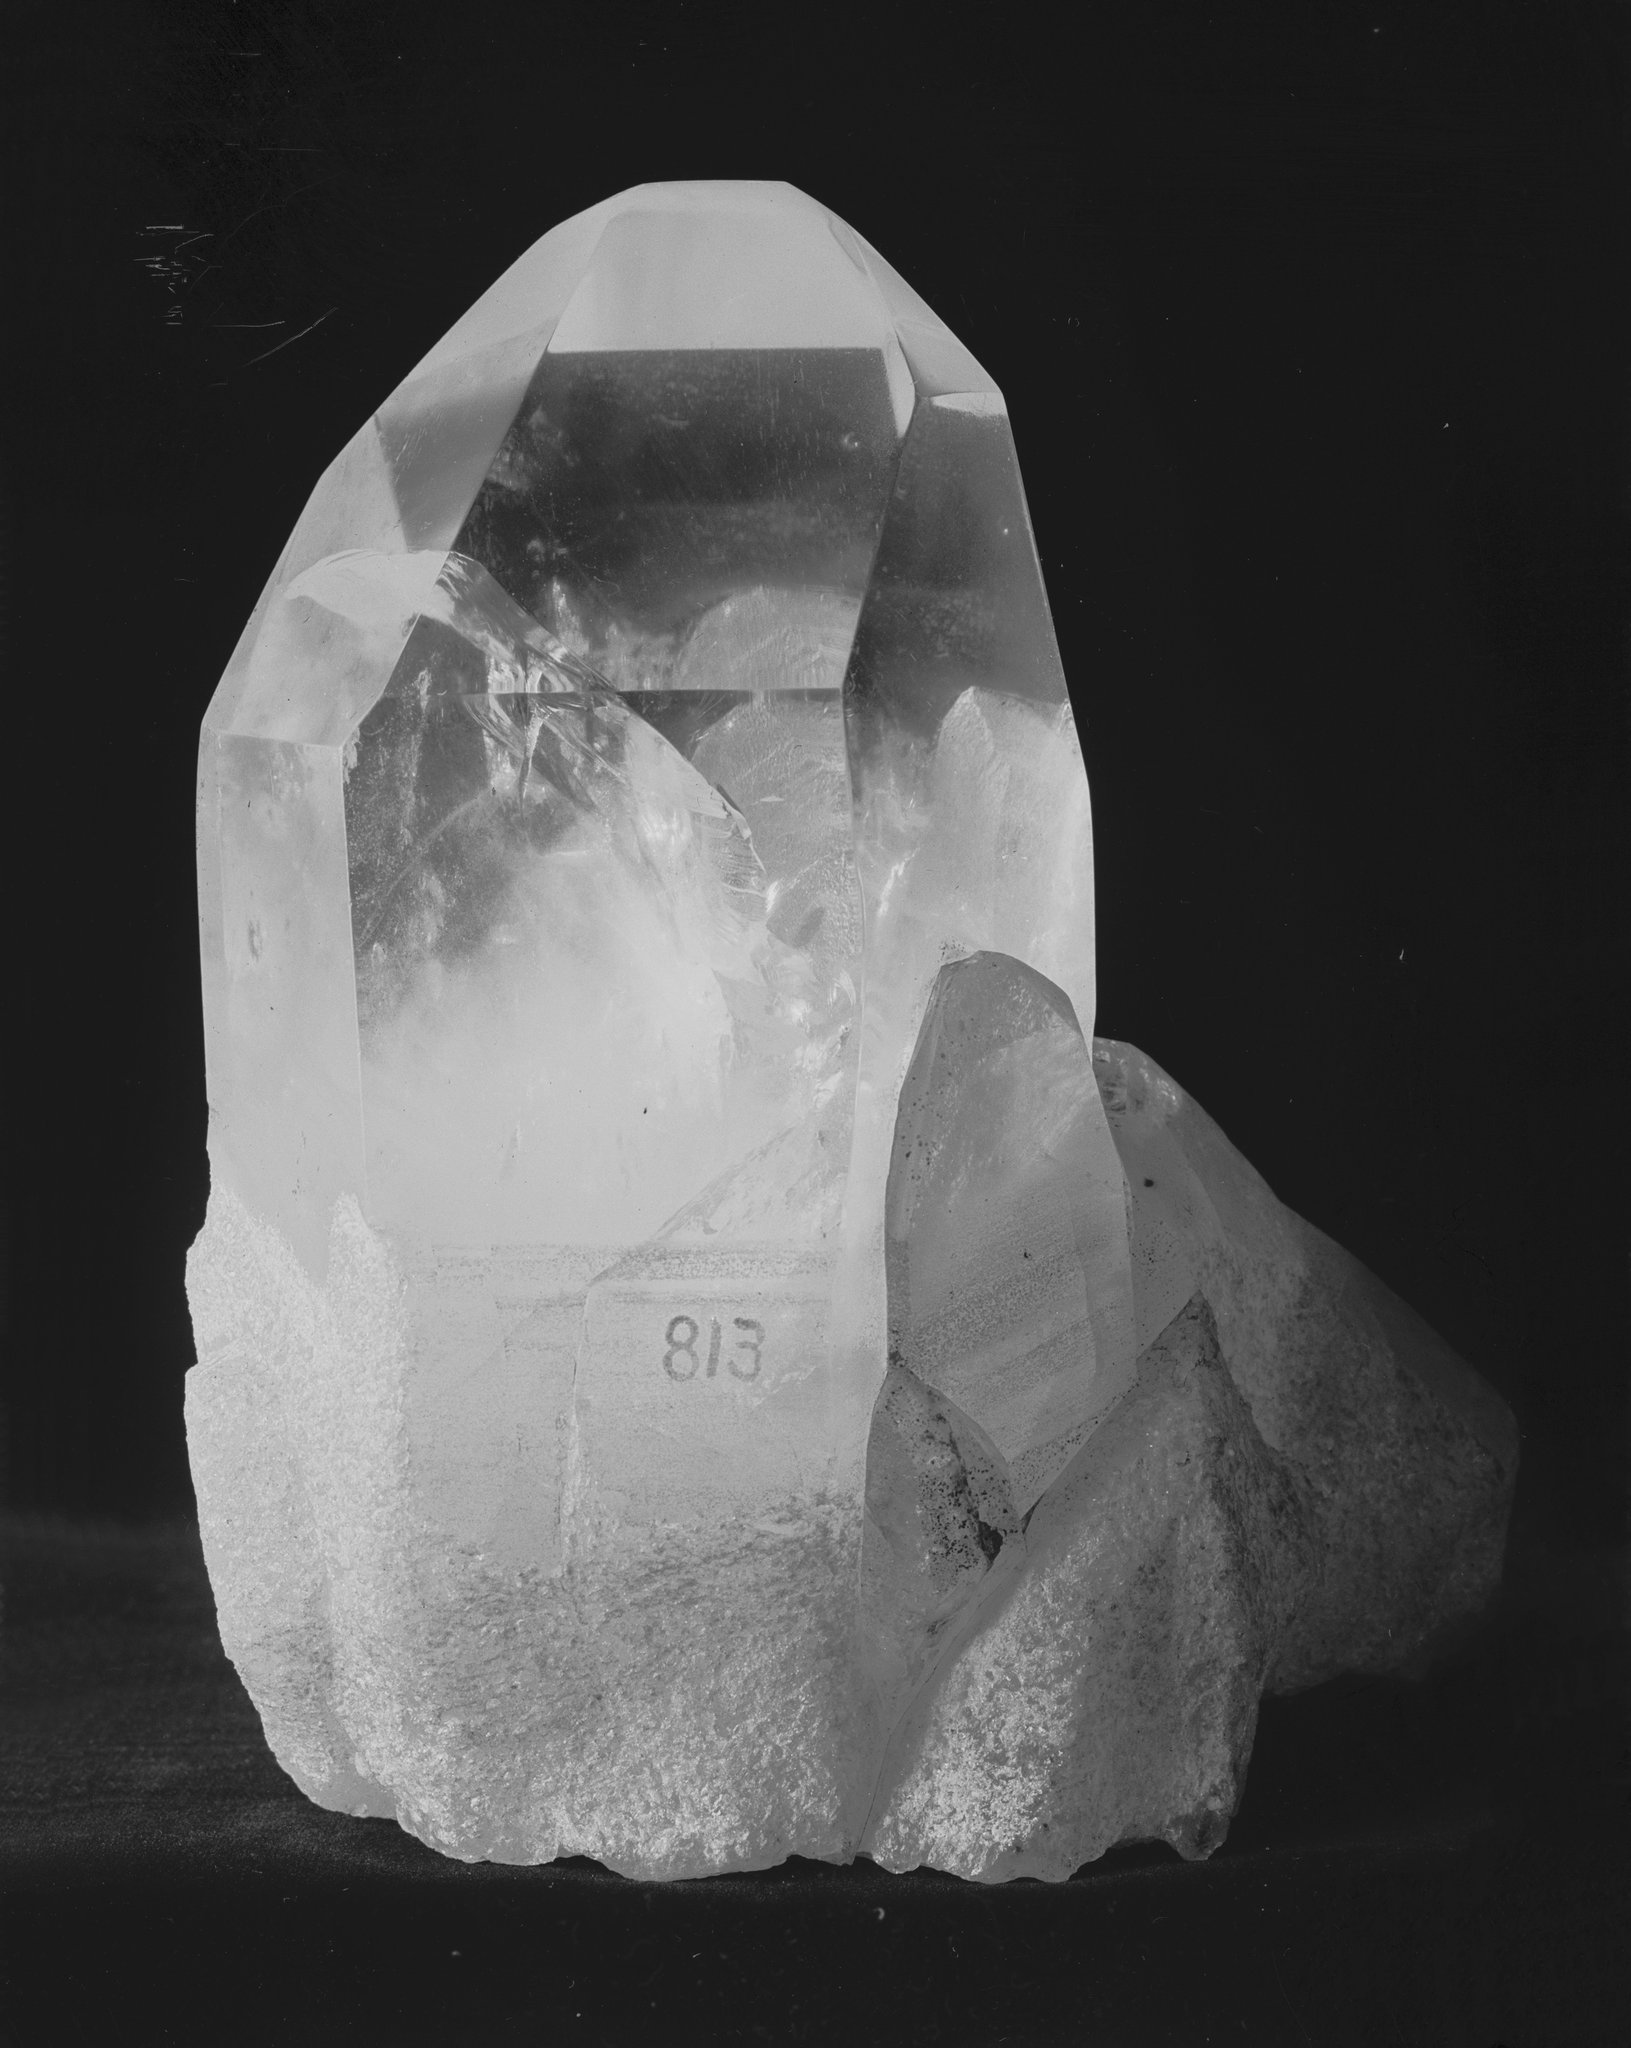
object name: crystal fragment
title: Fragment of Crystal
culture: chinese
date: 1701-1800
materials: quartz